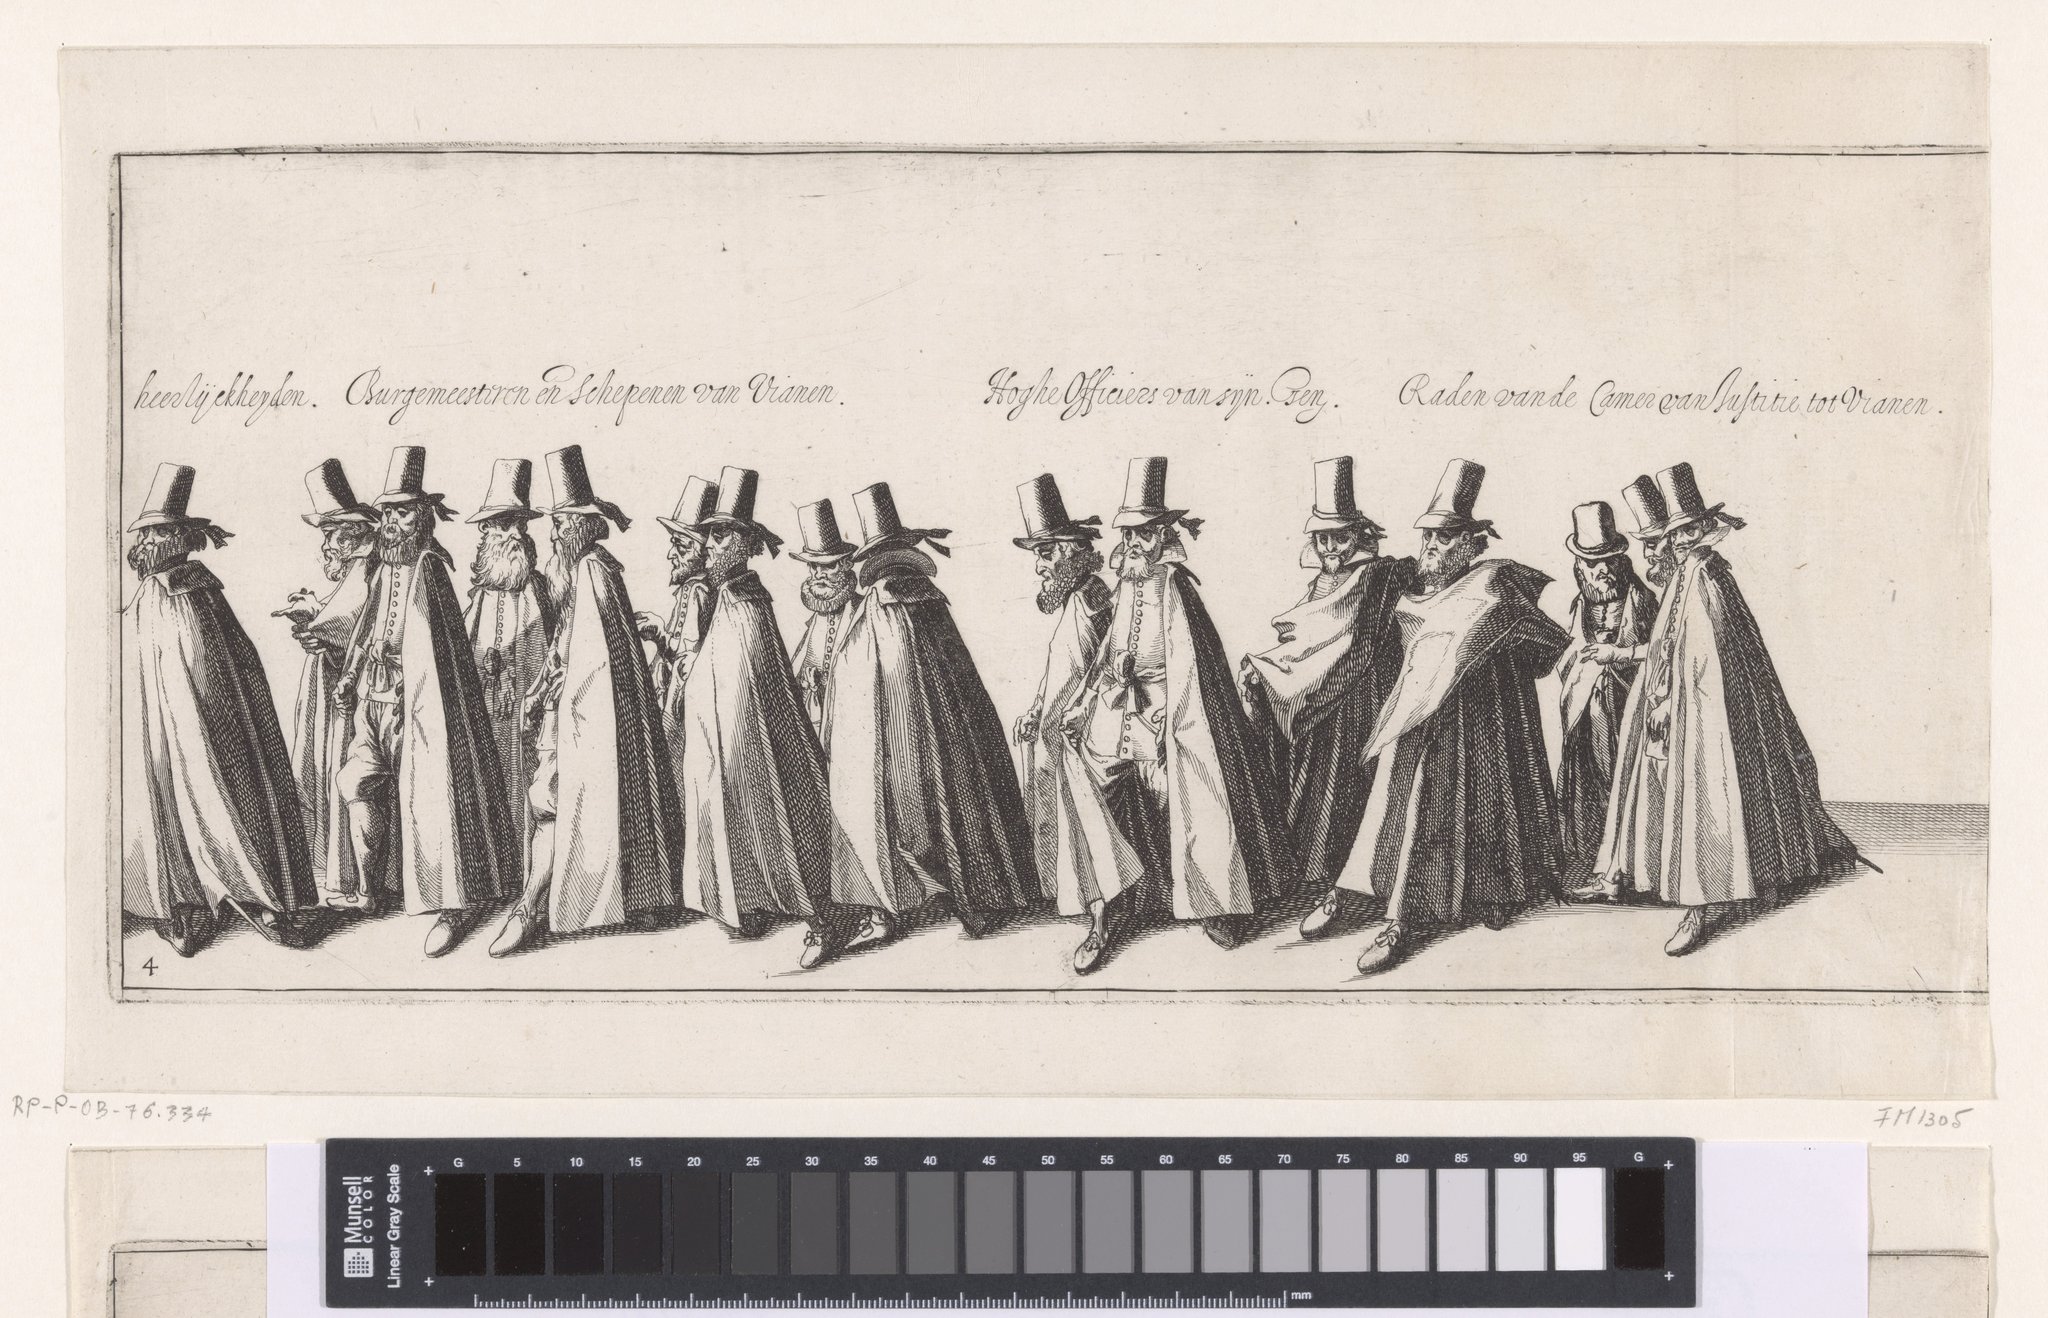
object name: print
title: Beschryvinge vande begraefnisse van (...) Walraven, Heere tot Brederoede, Vry-Heere van Vianen (...) Gedaen binnen der stede van vianen den XXIX Januari. Ano. 1615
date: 1615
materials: paper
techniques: etching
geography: northern netherlands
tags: cortege, funeral procession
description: De begrafenisstoet (plaat 4). Burgemeesters, officieren en raden van Vianen. Onderdeel van de serie prenten van de begrafenisoptocht van Walraven van Brederode, heer van Vianen, op 29 januari 1615 te Vianen.